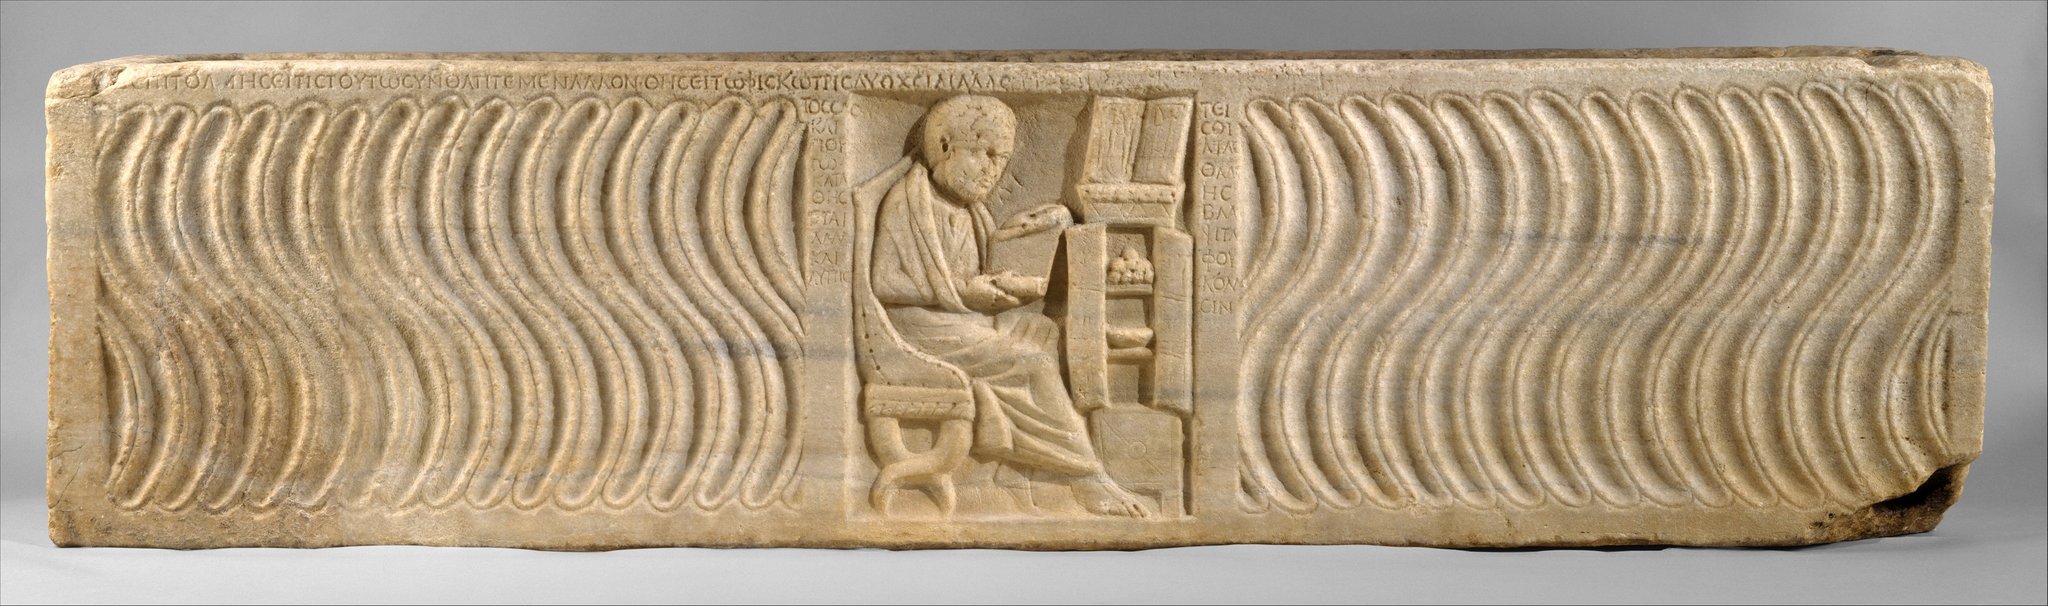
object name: sarcophagus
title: Sarcophagus with a Greek Physician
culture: roman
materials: marble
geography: ostia, rome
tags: men,doctors